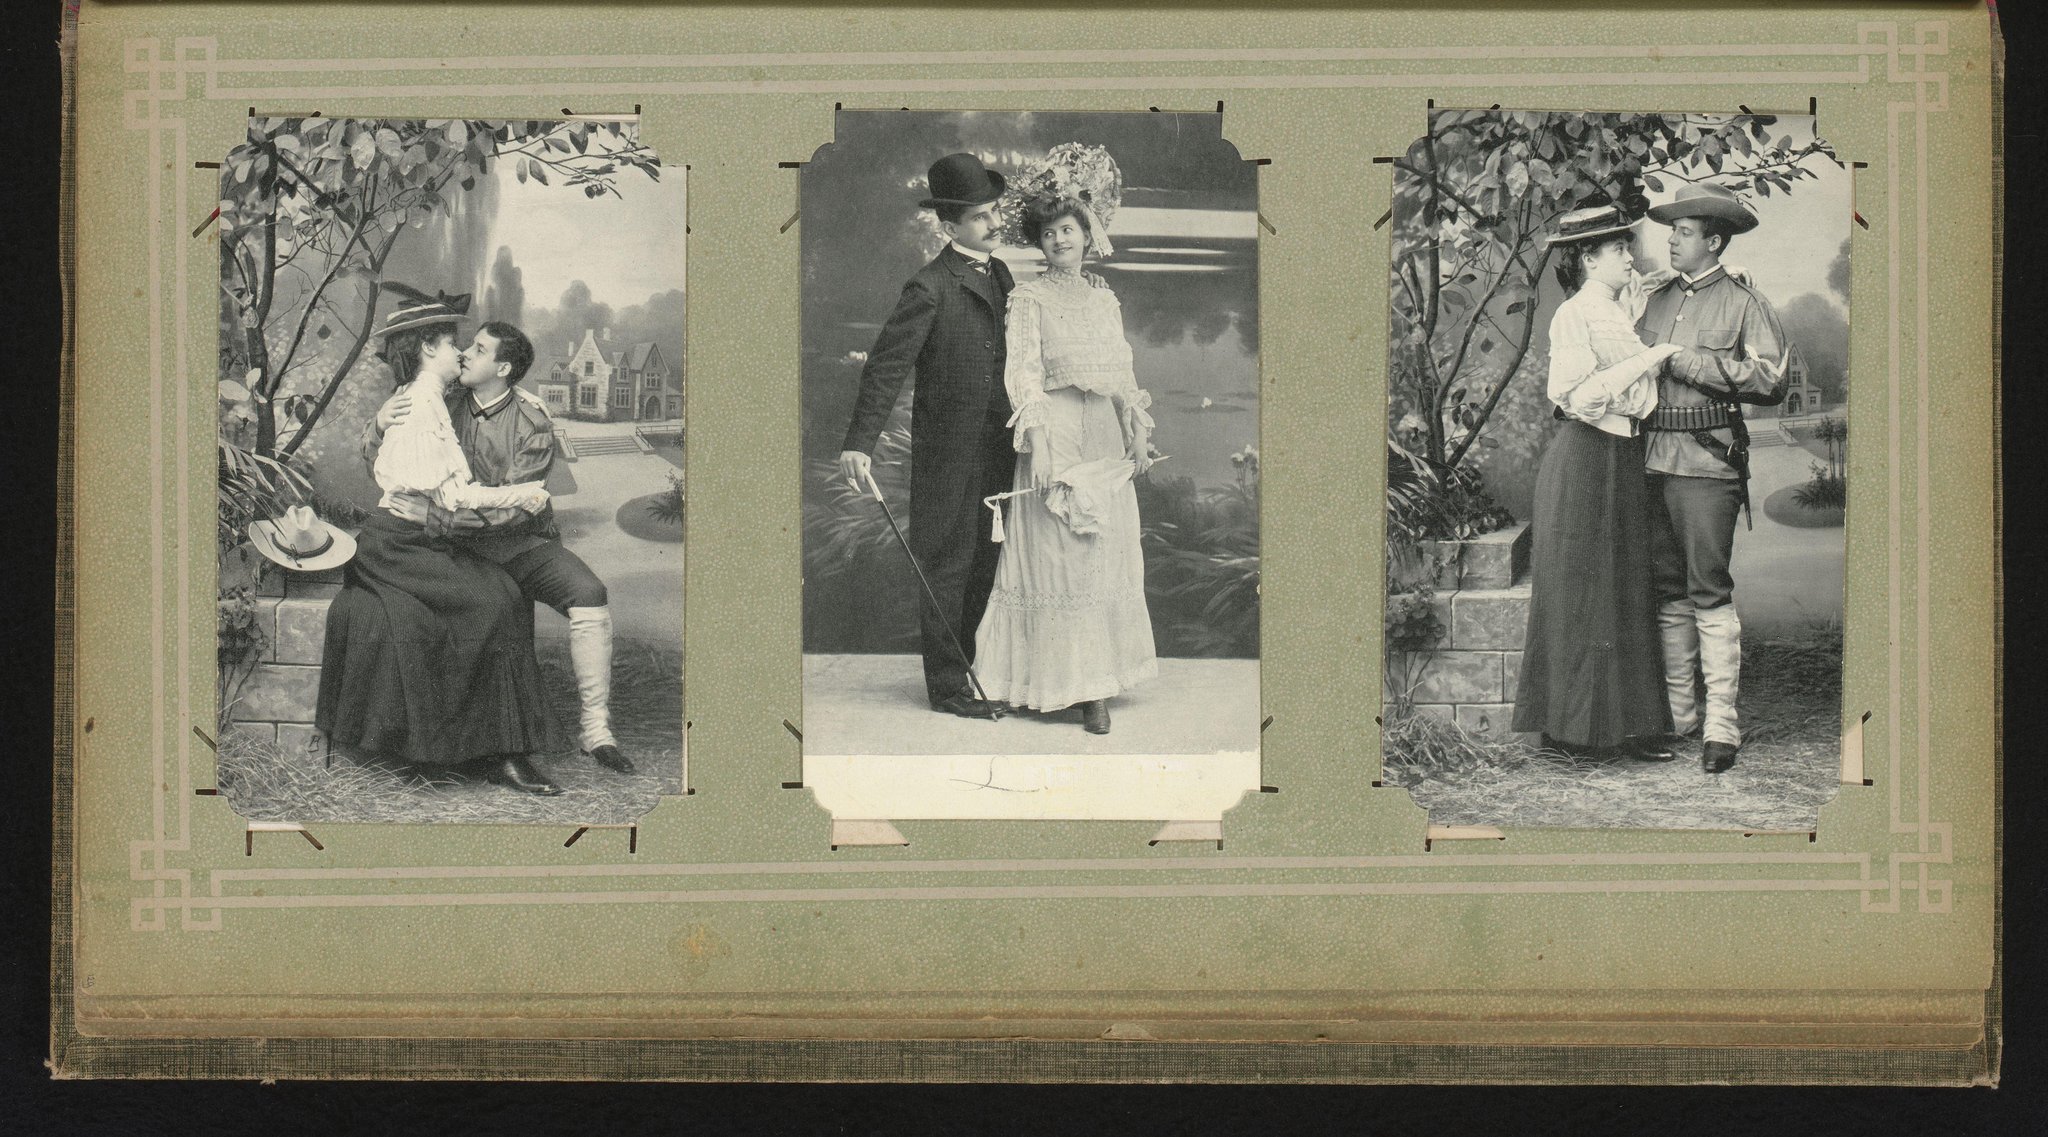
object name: photomechanical print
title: Drie portretten van een paar geliefden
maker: Anonymous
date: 1900-1930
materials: cardboard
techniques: autotype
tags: couple of lovers, historical persons (portraits and scenes from the life)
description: Deze prenten maken deel uit van een album.